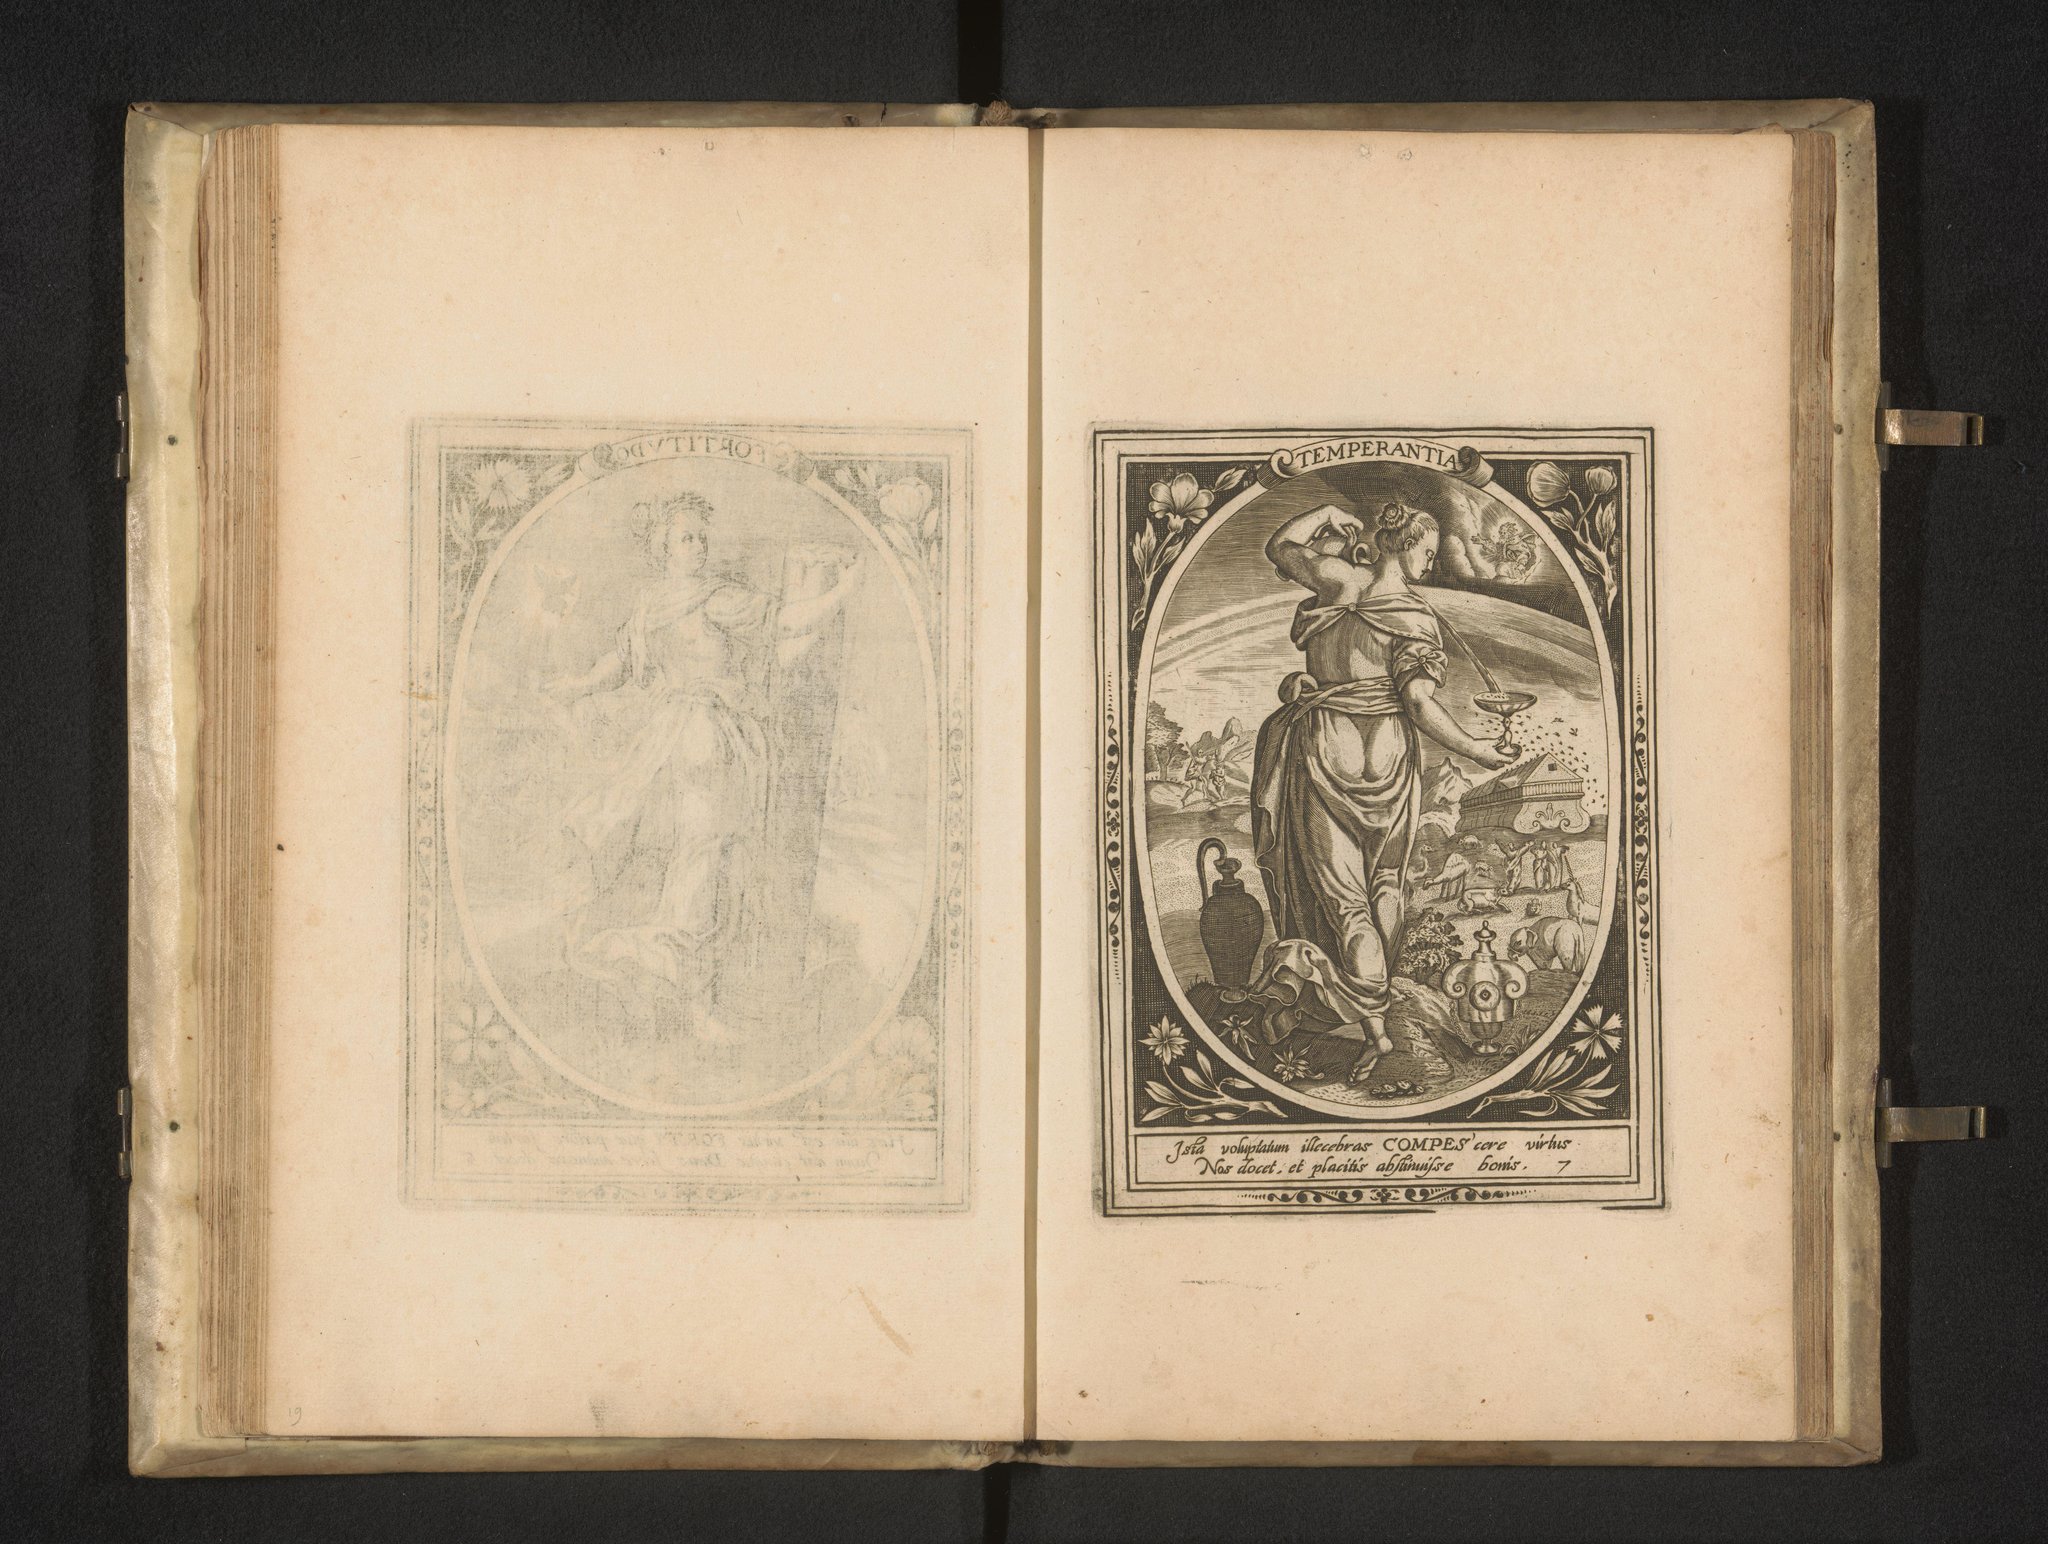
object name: print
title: Zeven theologische en kardinale deugden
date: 1600-1670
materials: paper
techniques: engraving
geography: antwerp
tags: temperance, 'temperantia'; 'temperanza' (ripa) ~ one of the four cardinal virtues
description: De Matigheid (Temperantia). Genummered rechtsonder: 7. Onderdeel van de serie van zeven theologische en kardinale deugden. Onderdeel van een album met voornamelijk christelijke voorstellingen.